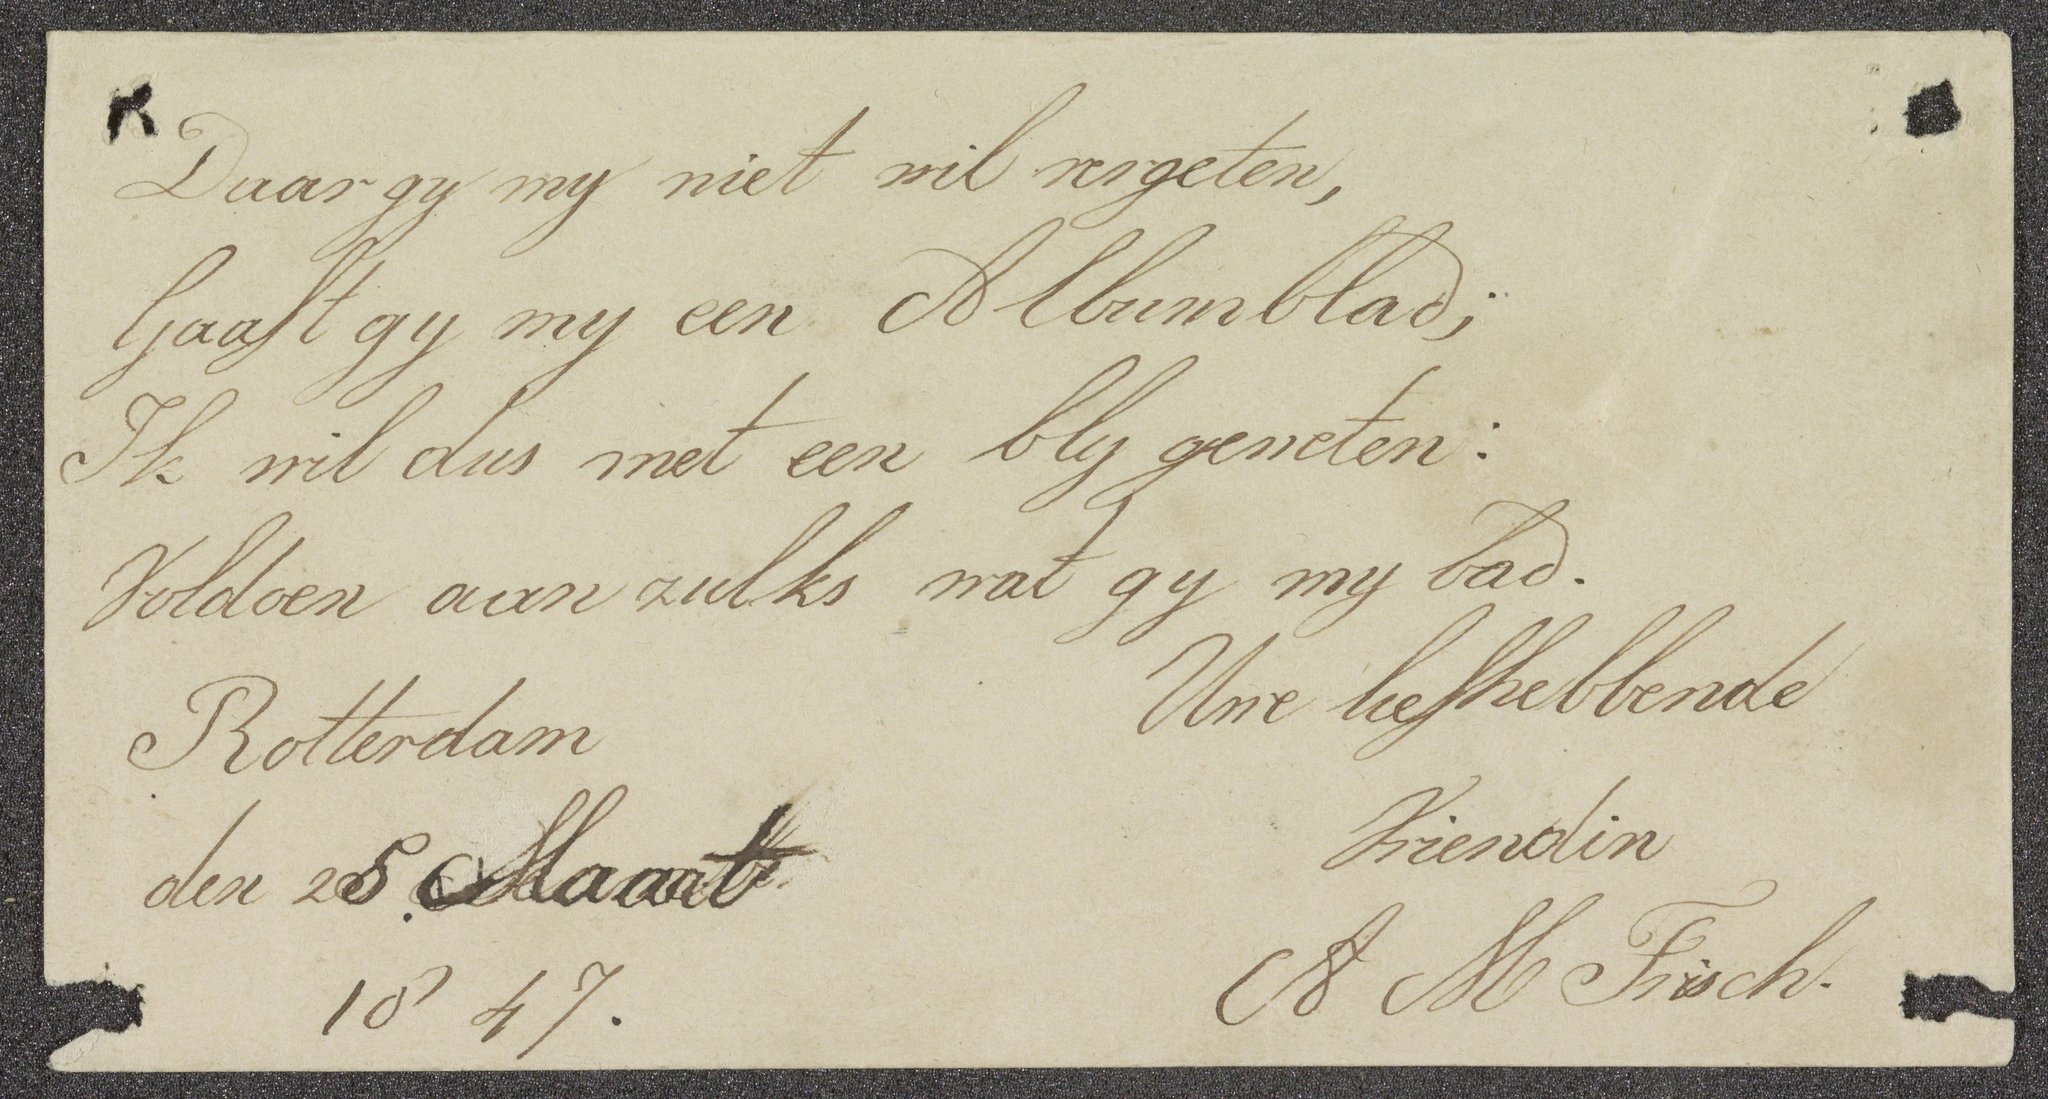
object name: album leaf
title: Geschreven tekst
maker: a.m. frisch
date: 1847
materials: paper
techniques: writing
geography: rotterdam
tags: 'album amicorum', 'stammbuch'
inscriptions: inscription: ‘Daar gy my niet wil vergeten/ Gaaft gy my een albumblad/ Ik wil dus met een bly geweten/ Voldoen aan zulks war gy my bad. // Rotterdam den 25. Maart 1847/ Uw liefhebbende Vriendin A.M. Frisch’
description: Het albumblad behoort bij een geborduurde staande hond op geperforeerd karton (BI-2006-4185-2A).